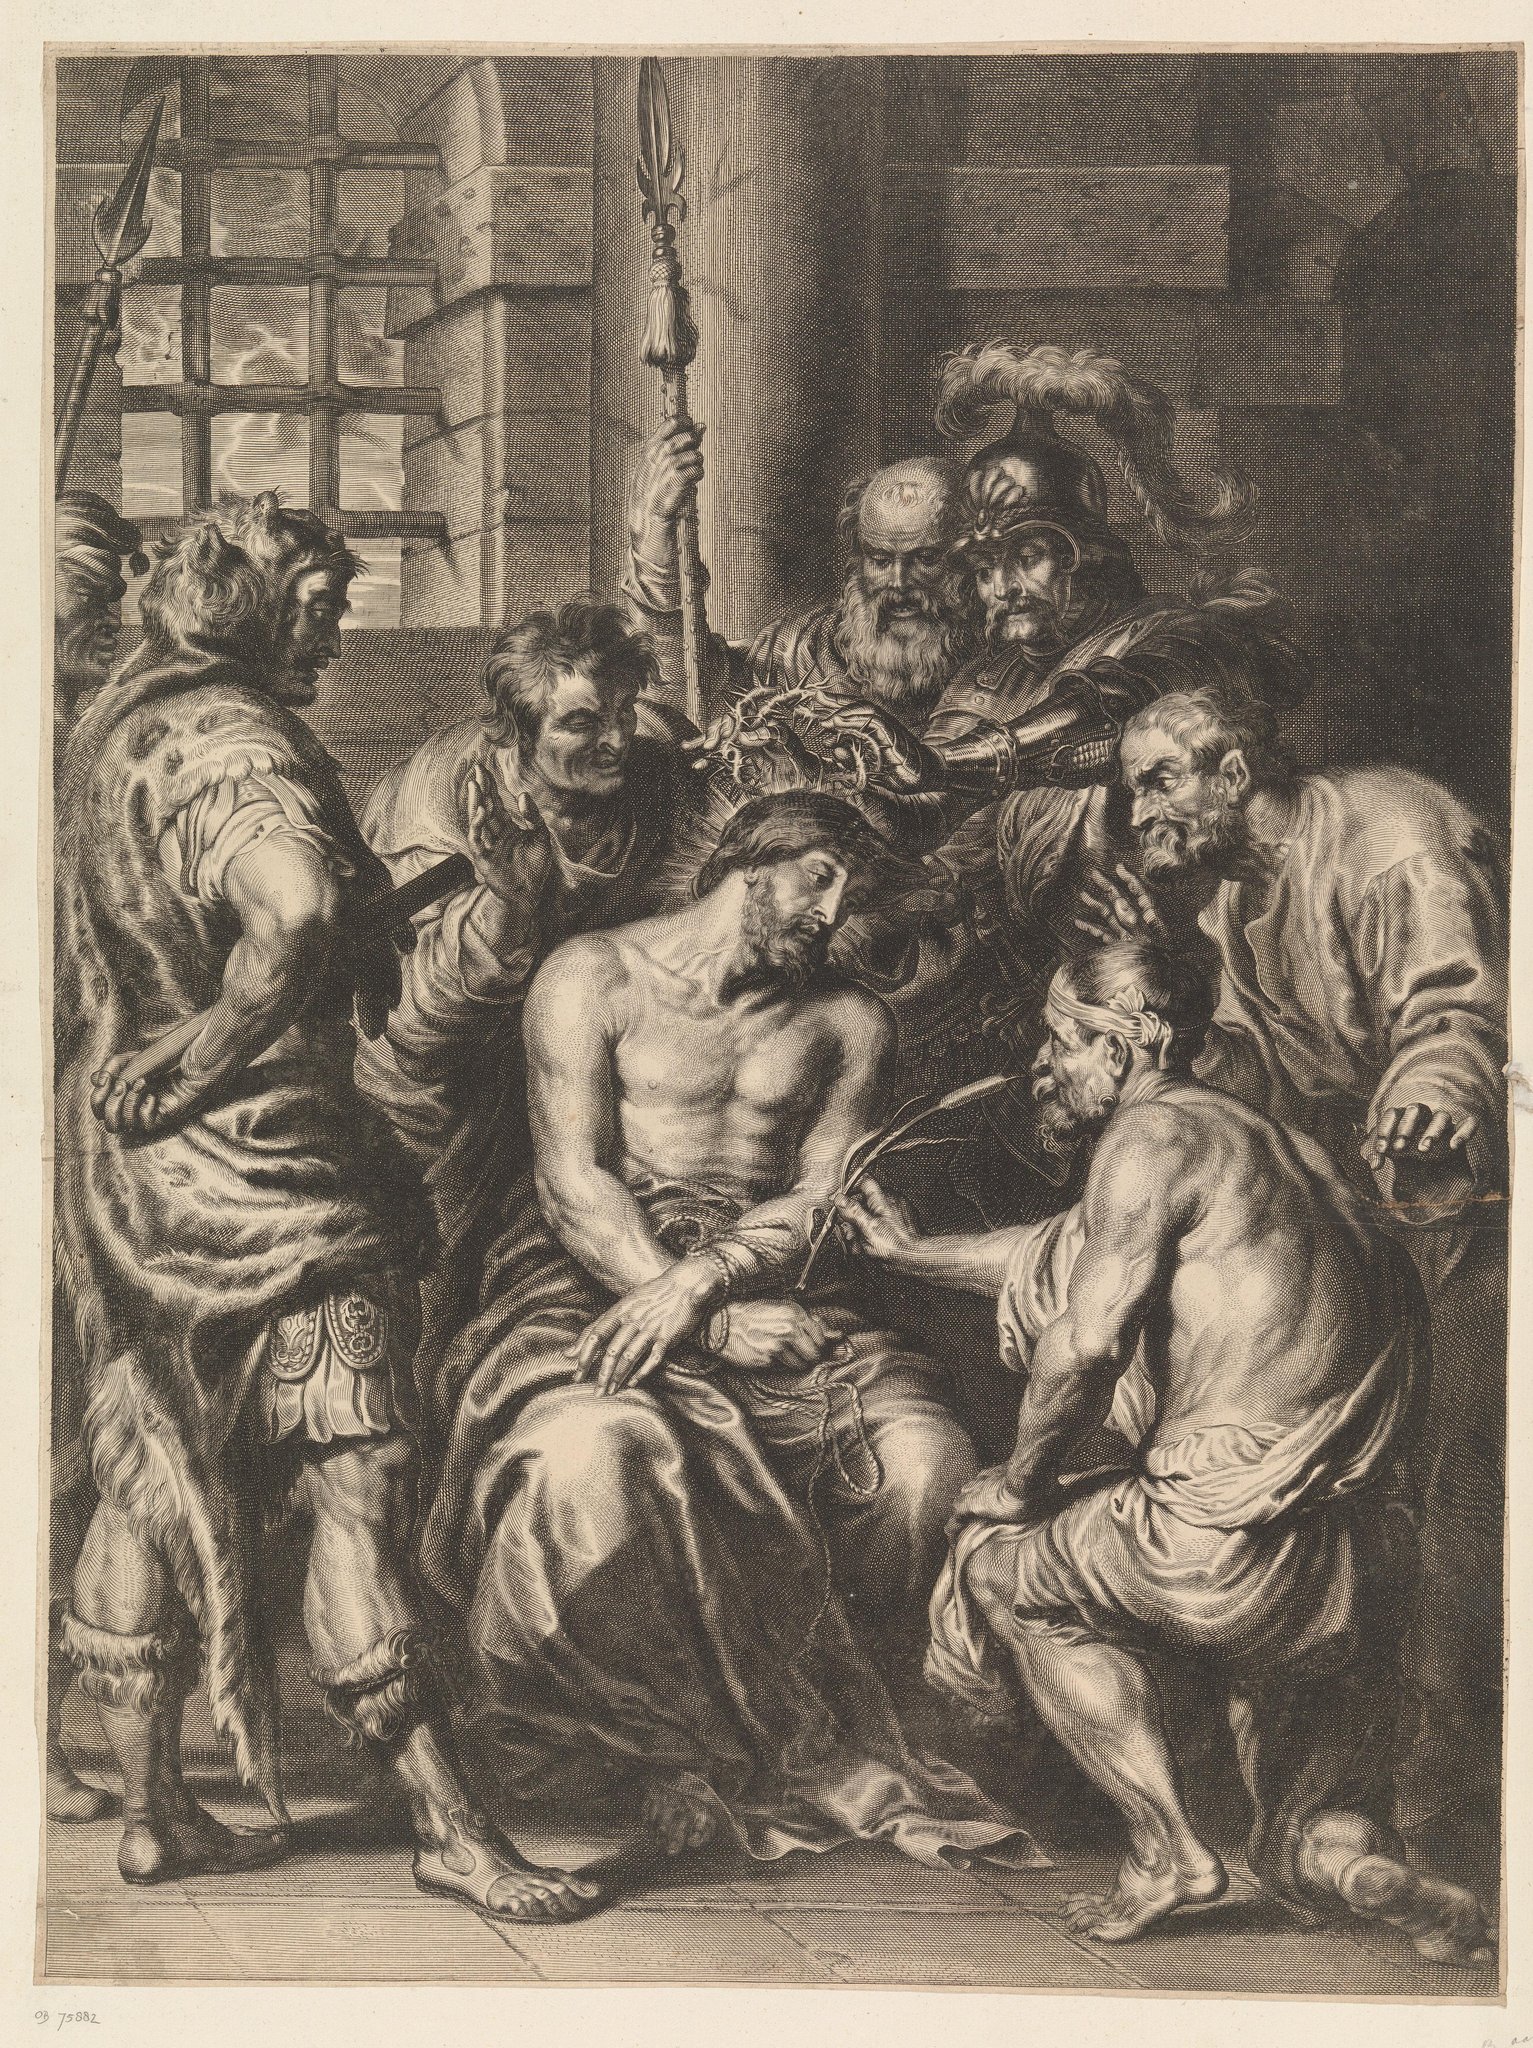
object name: album leaf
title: Bespotting en doornenkroning van Christus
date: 1630-1654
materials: paper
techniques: engraving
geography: antwerp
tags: the crowning with thorns: soldiers with sticks place a thorny crown on christ's head and give him a reed (matthew 27:27-31; mark 15:16-20; john 19:2-3)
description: Christus wordt door een soldaat met een doornenkroon gekroond en hij krijgt van een andere man een rietstengel als scepter. Links een soldaat gekleed in een leeuwenvel. Onderaan in de marge een verwijzing naar de Bijbeltekst in Mat. 27 in het Latijn. Deze prent maakt deel uit van een album.